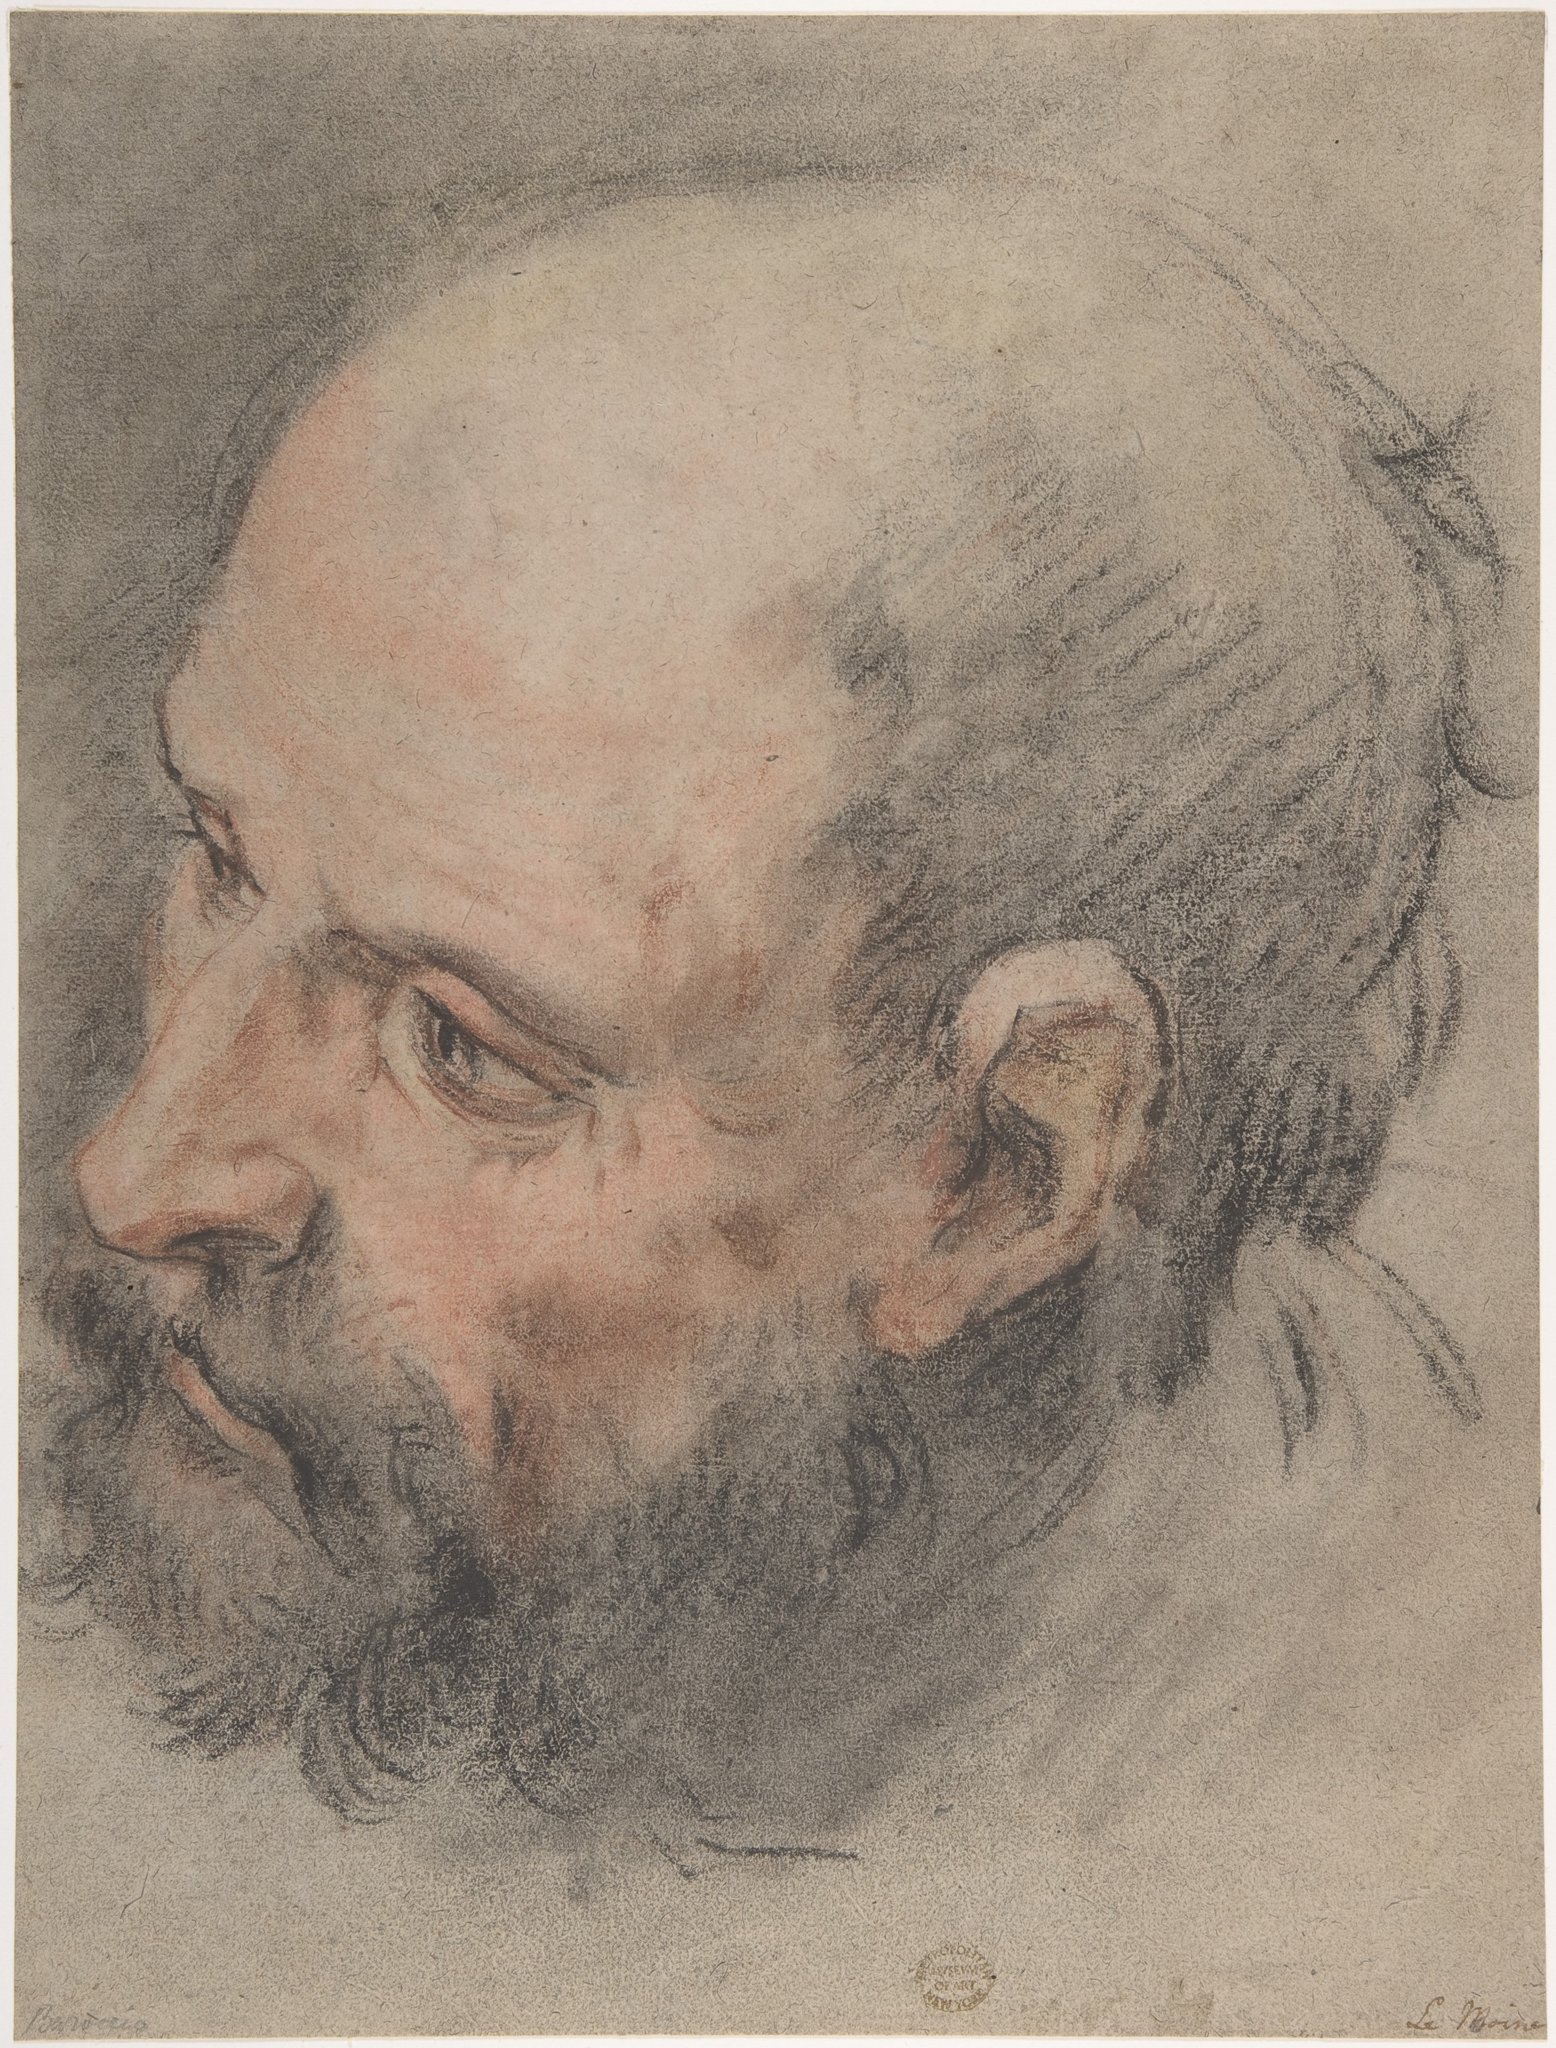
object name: drawing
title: Head of a Bearded Man Looking Left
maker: françois le moyne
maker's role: artist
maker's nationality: french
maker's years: 1688-1737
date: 1701-1733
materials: chalk, paper, pastel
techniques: stumping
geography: france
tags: heads,men